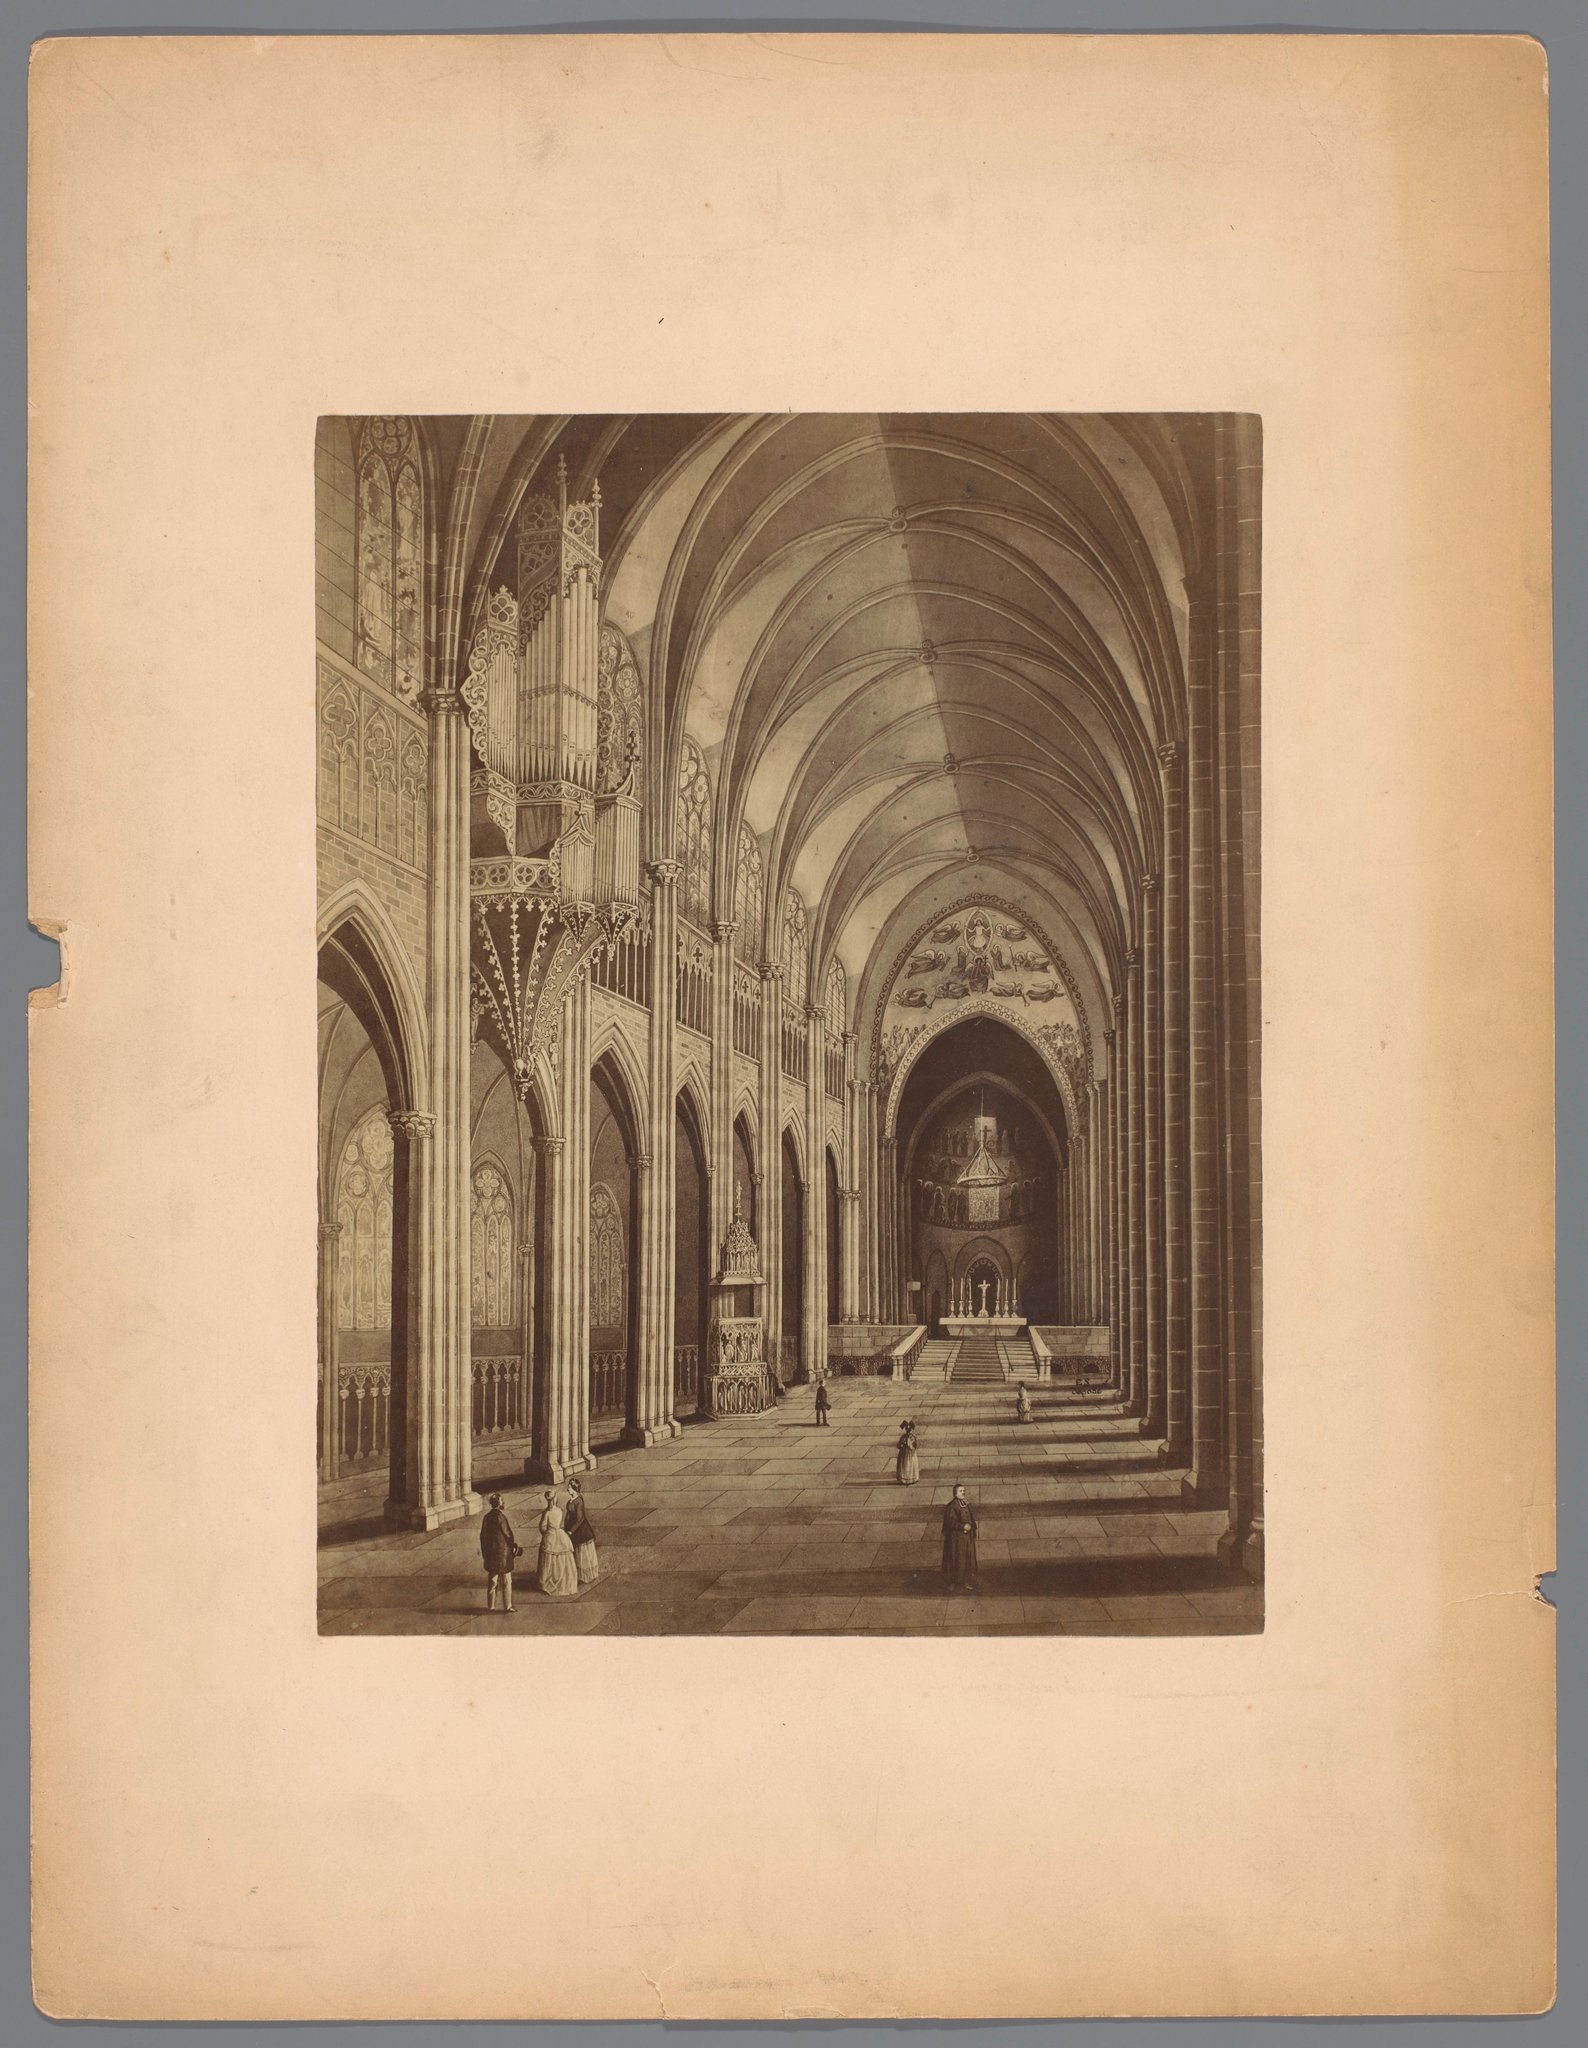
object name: photograph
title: Fotoreproductie van een tekening, voorstellende het interieur van een kerk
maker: Anonymous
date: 1875-1900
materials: cardboard, photographic support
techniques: albumen print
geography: europe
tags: church organ, pulpit, ambo, chancel, parts of church interior: choir, europe